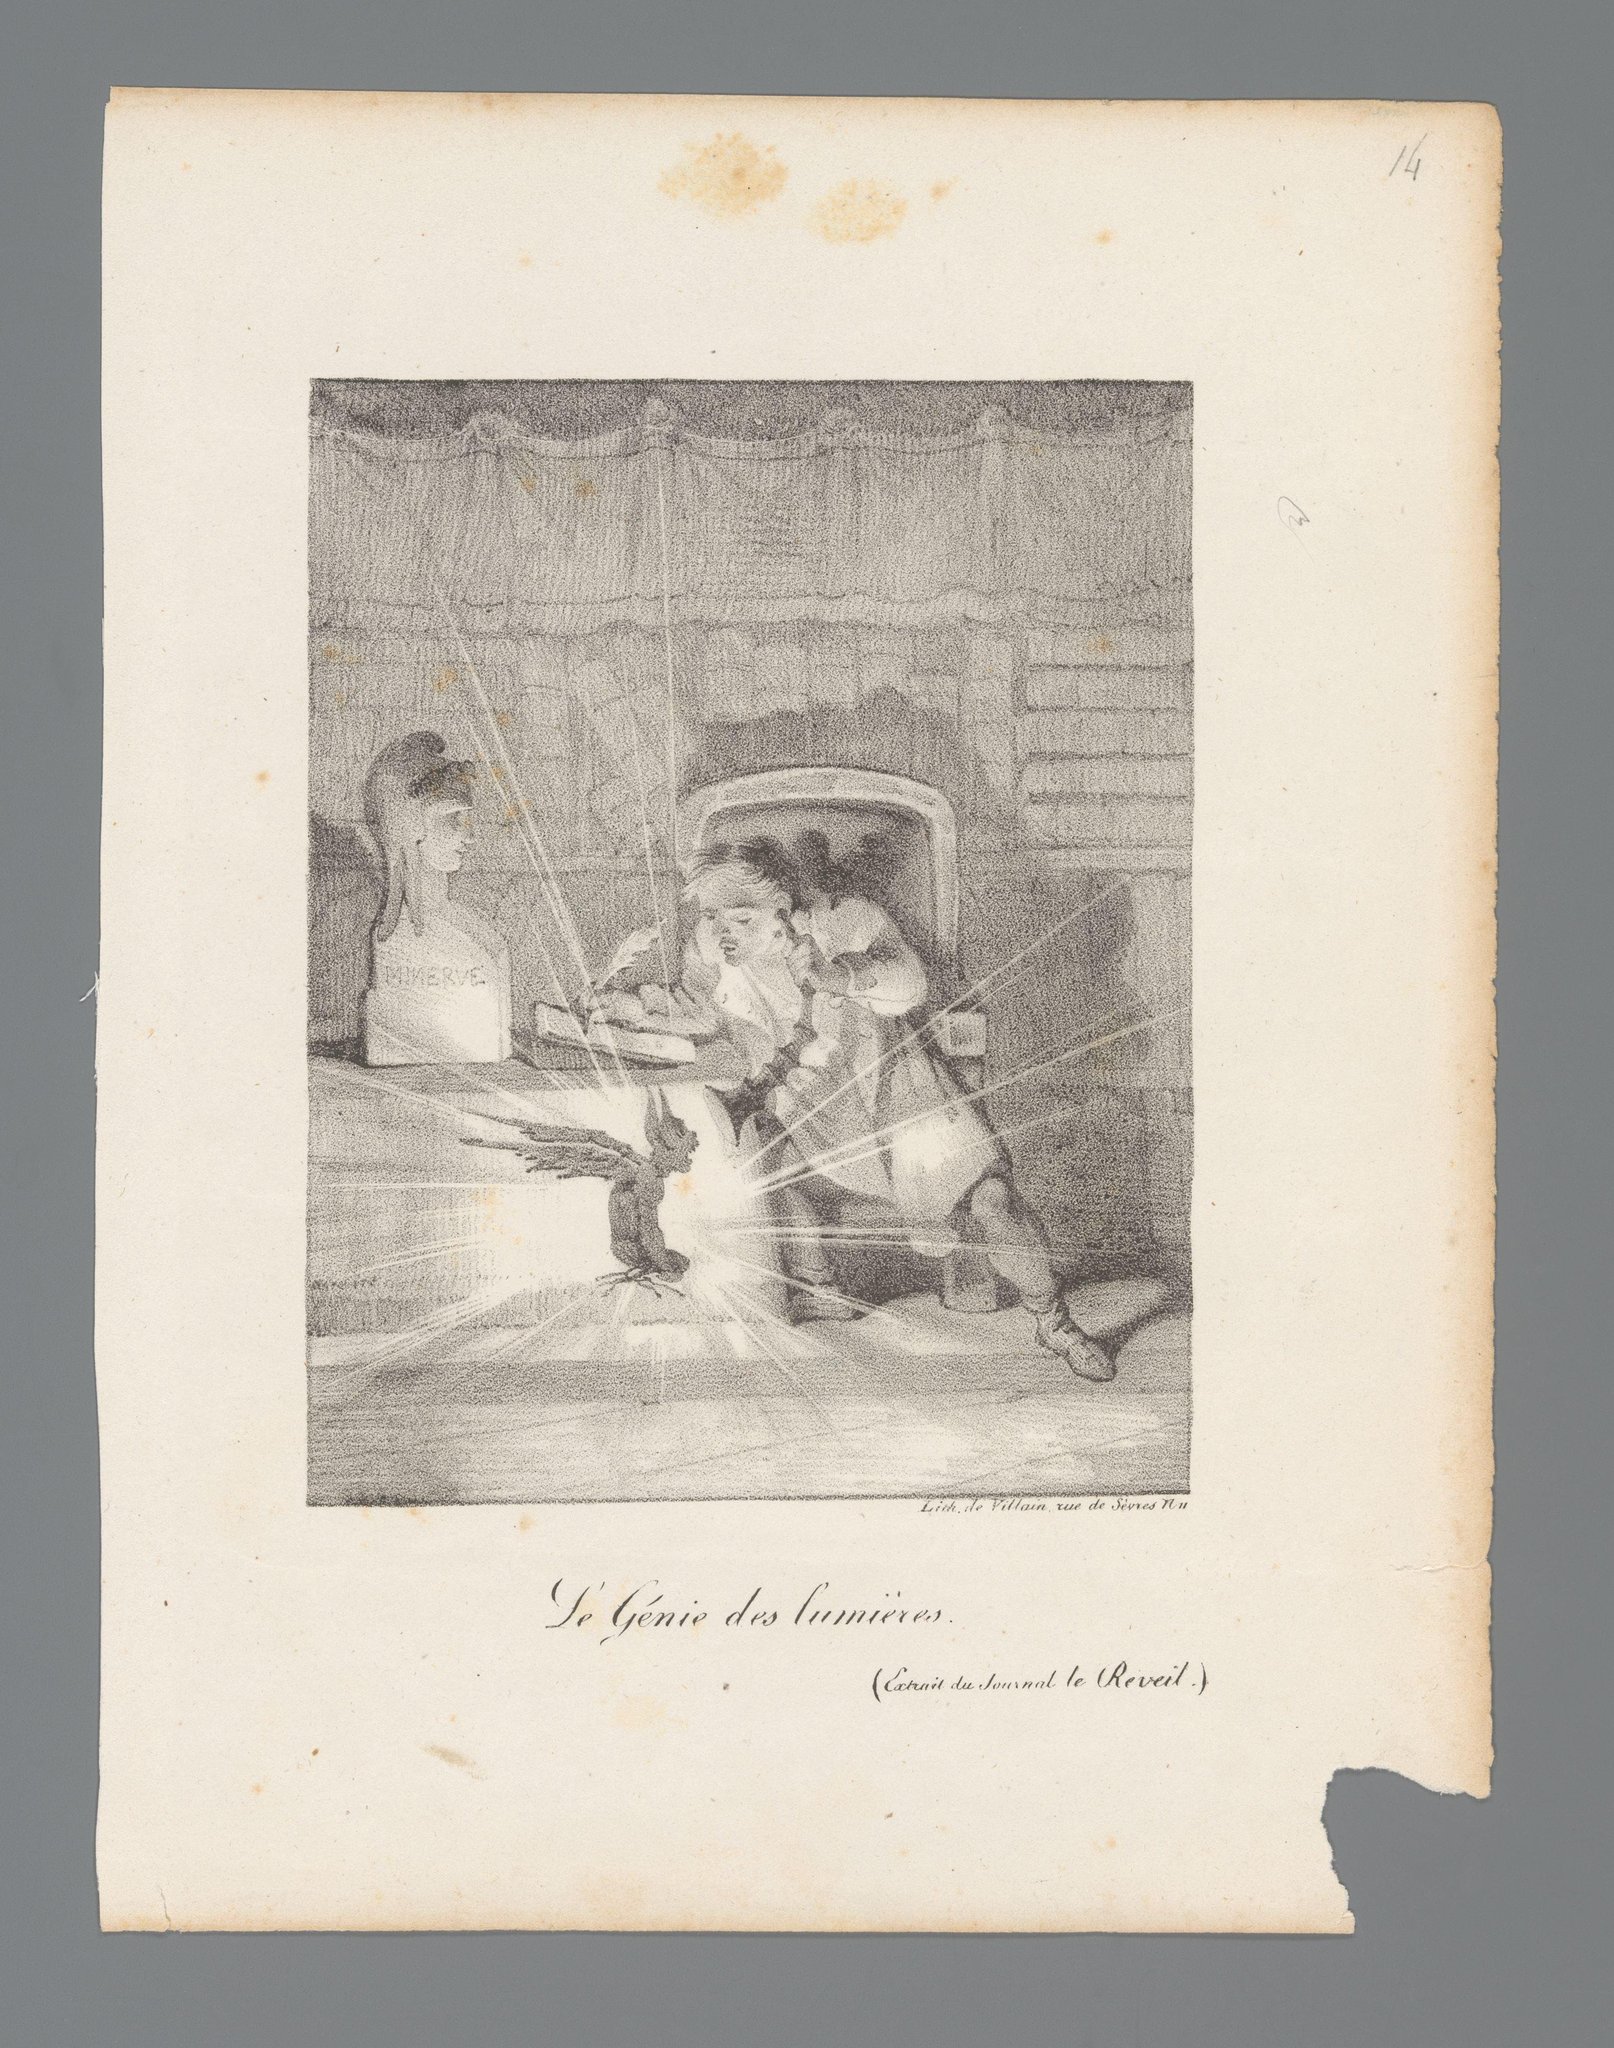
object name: cartoon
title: Le génie des lumières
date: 1822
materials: paper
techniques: lithograph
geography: paris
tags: journalist, reporter, devil(s) and demons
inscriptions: collector's mark: Lugt 2228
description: Prent uit: Le Réveil, journal des sciences, de la littérature, des moeurs, théâtres et beaux-arts (1822), nr. 89, 28 oktober 1822.